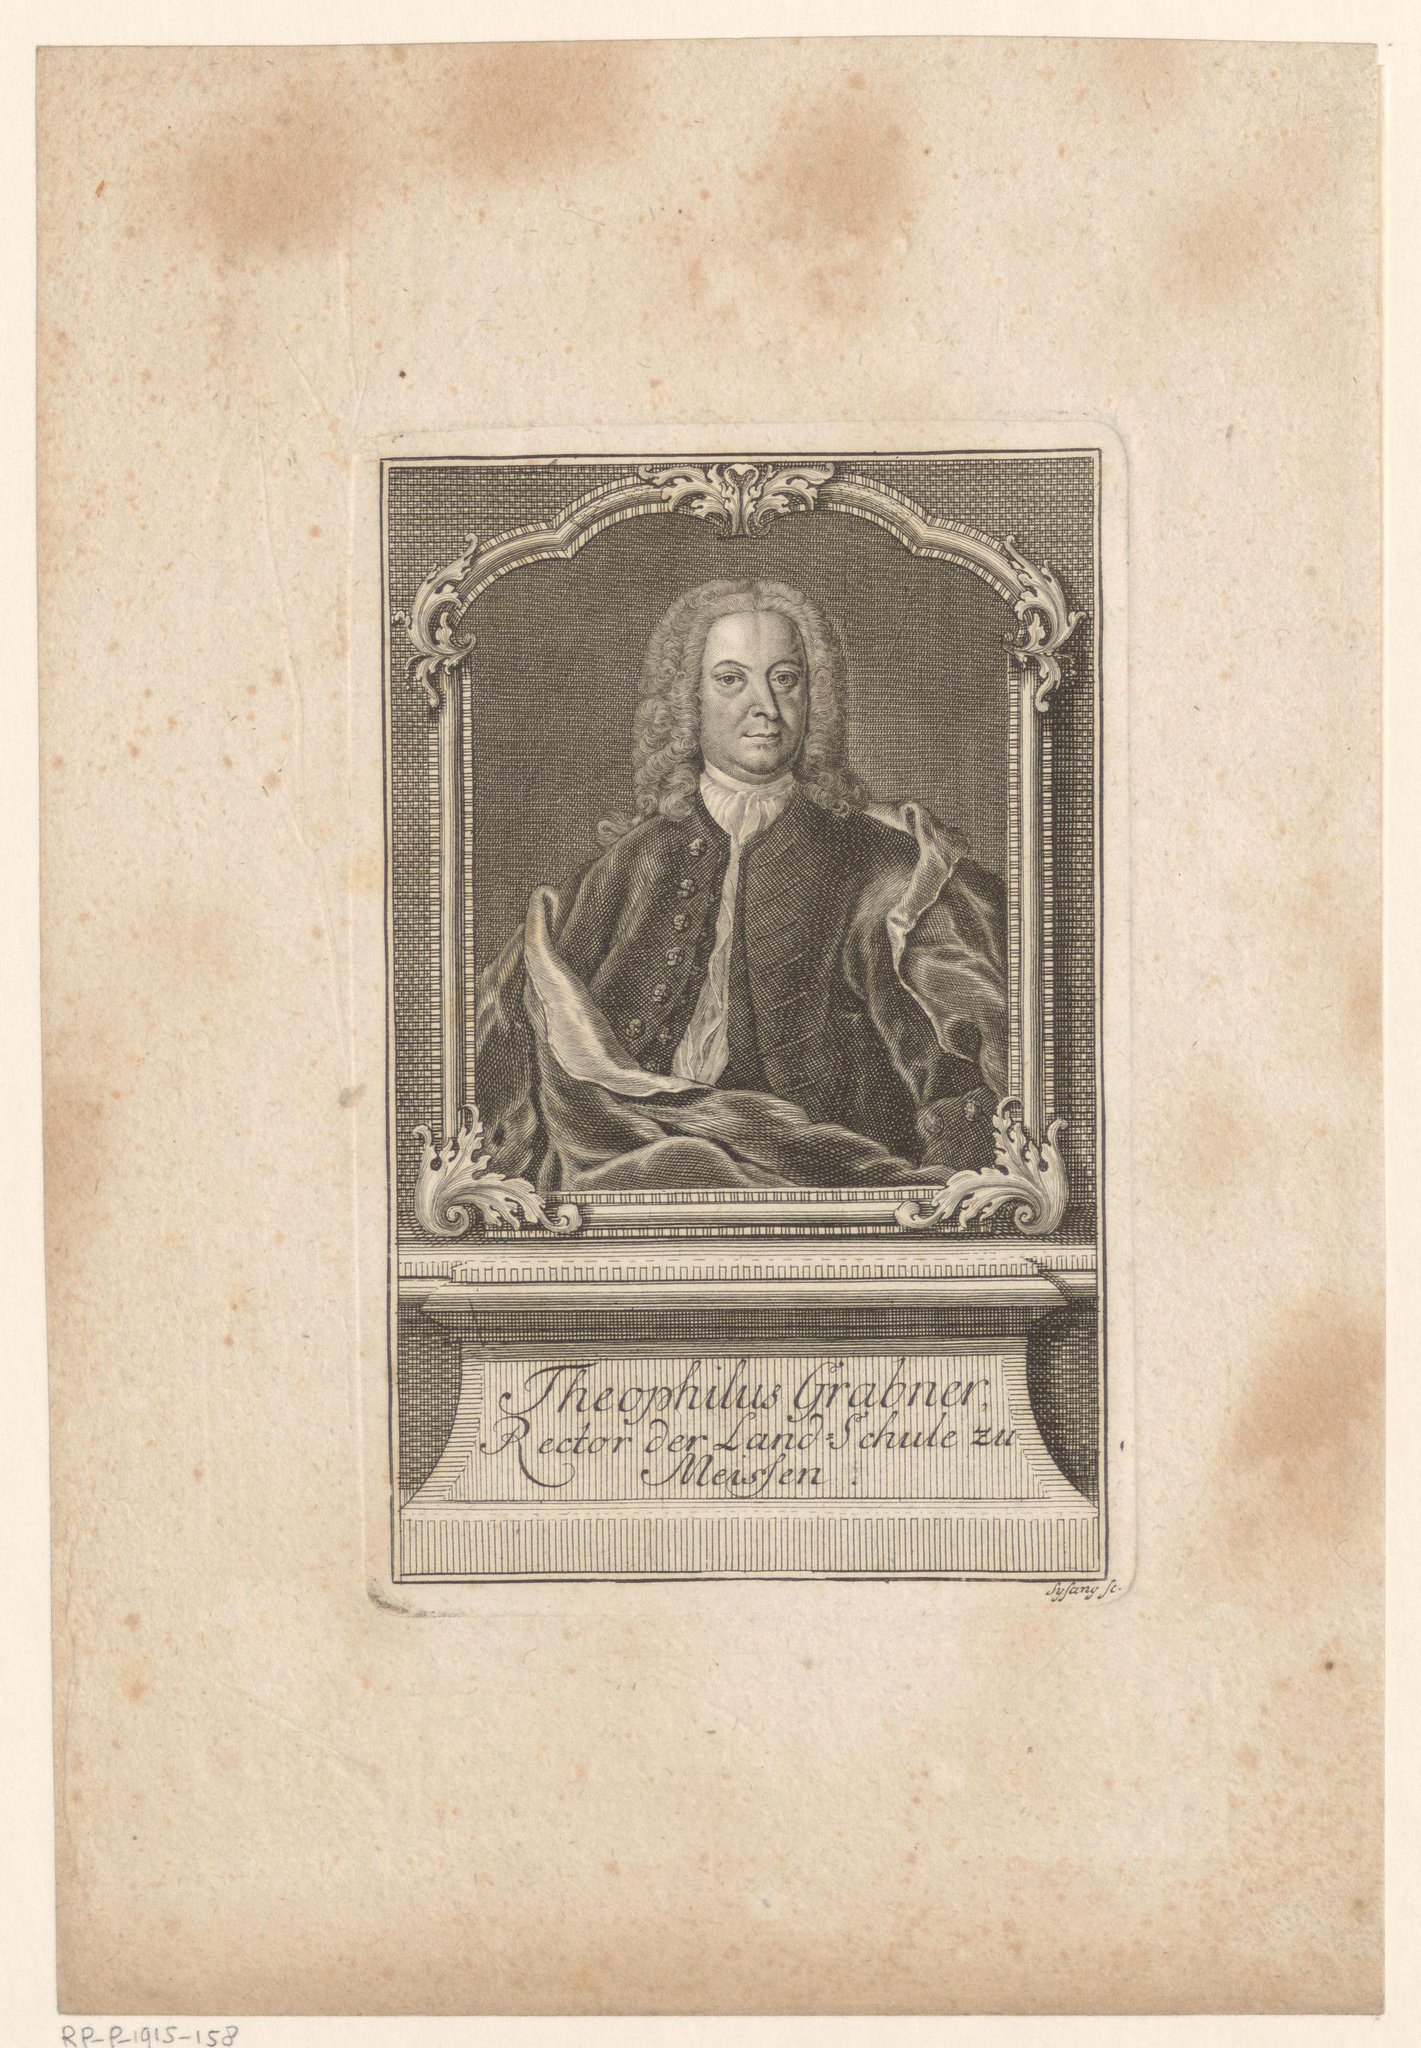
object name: print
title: Portret van Theophilus Grabener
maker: johann christoph sysang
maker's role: print maker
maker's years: 1703-1757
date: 1735-1757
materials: paper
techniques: engraving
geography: leipzig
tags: historical persons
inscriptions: collector's mark: Lugt 2228